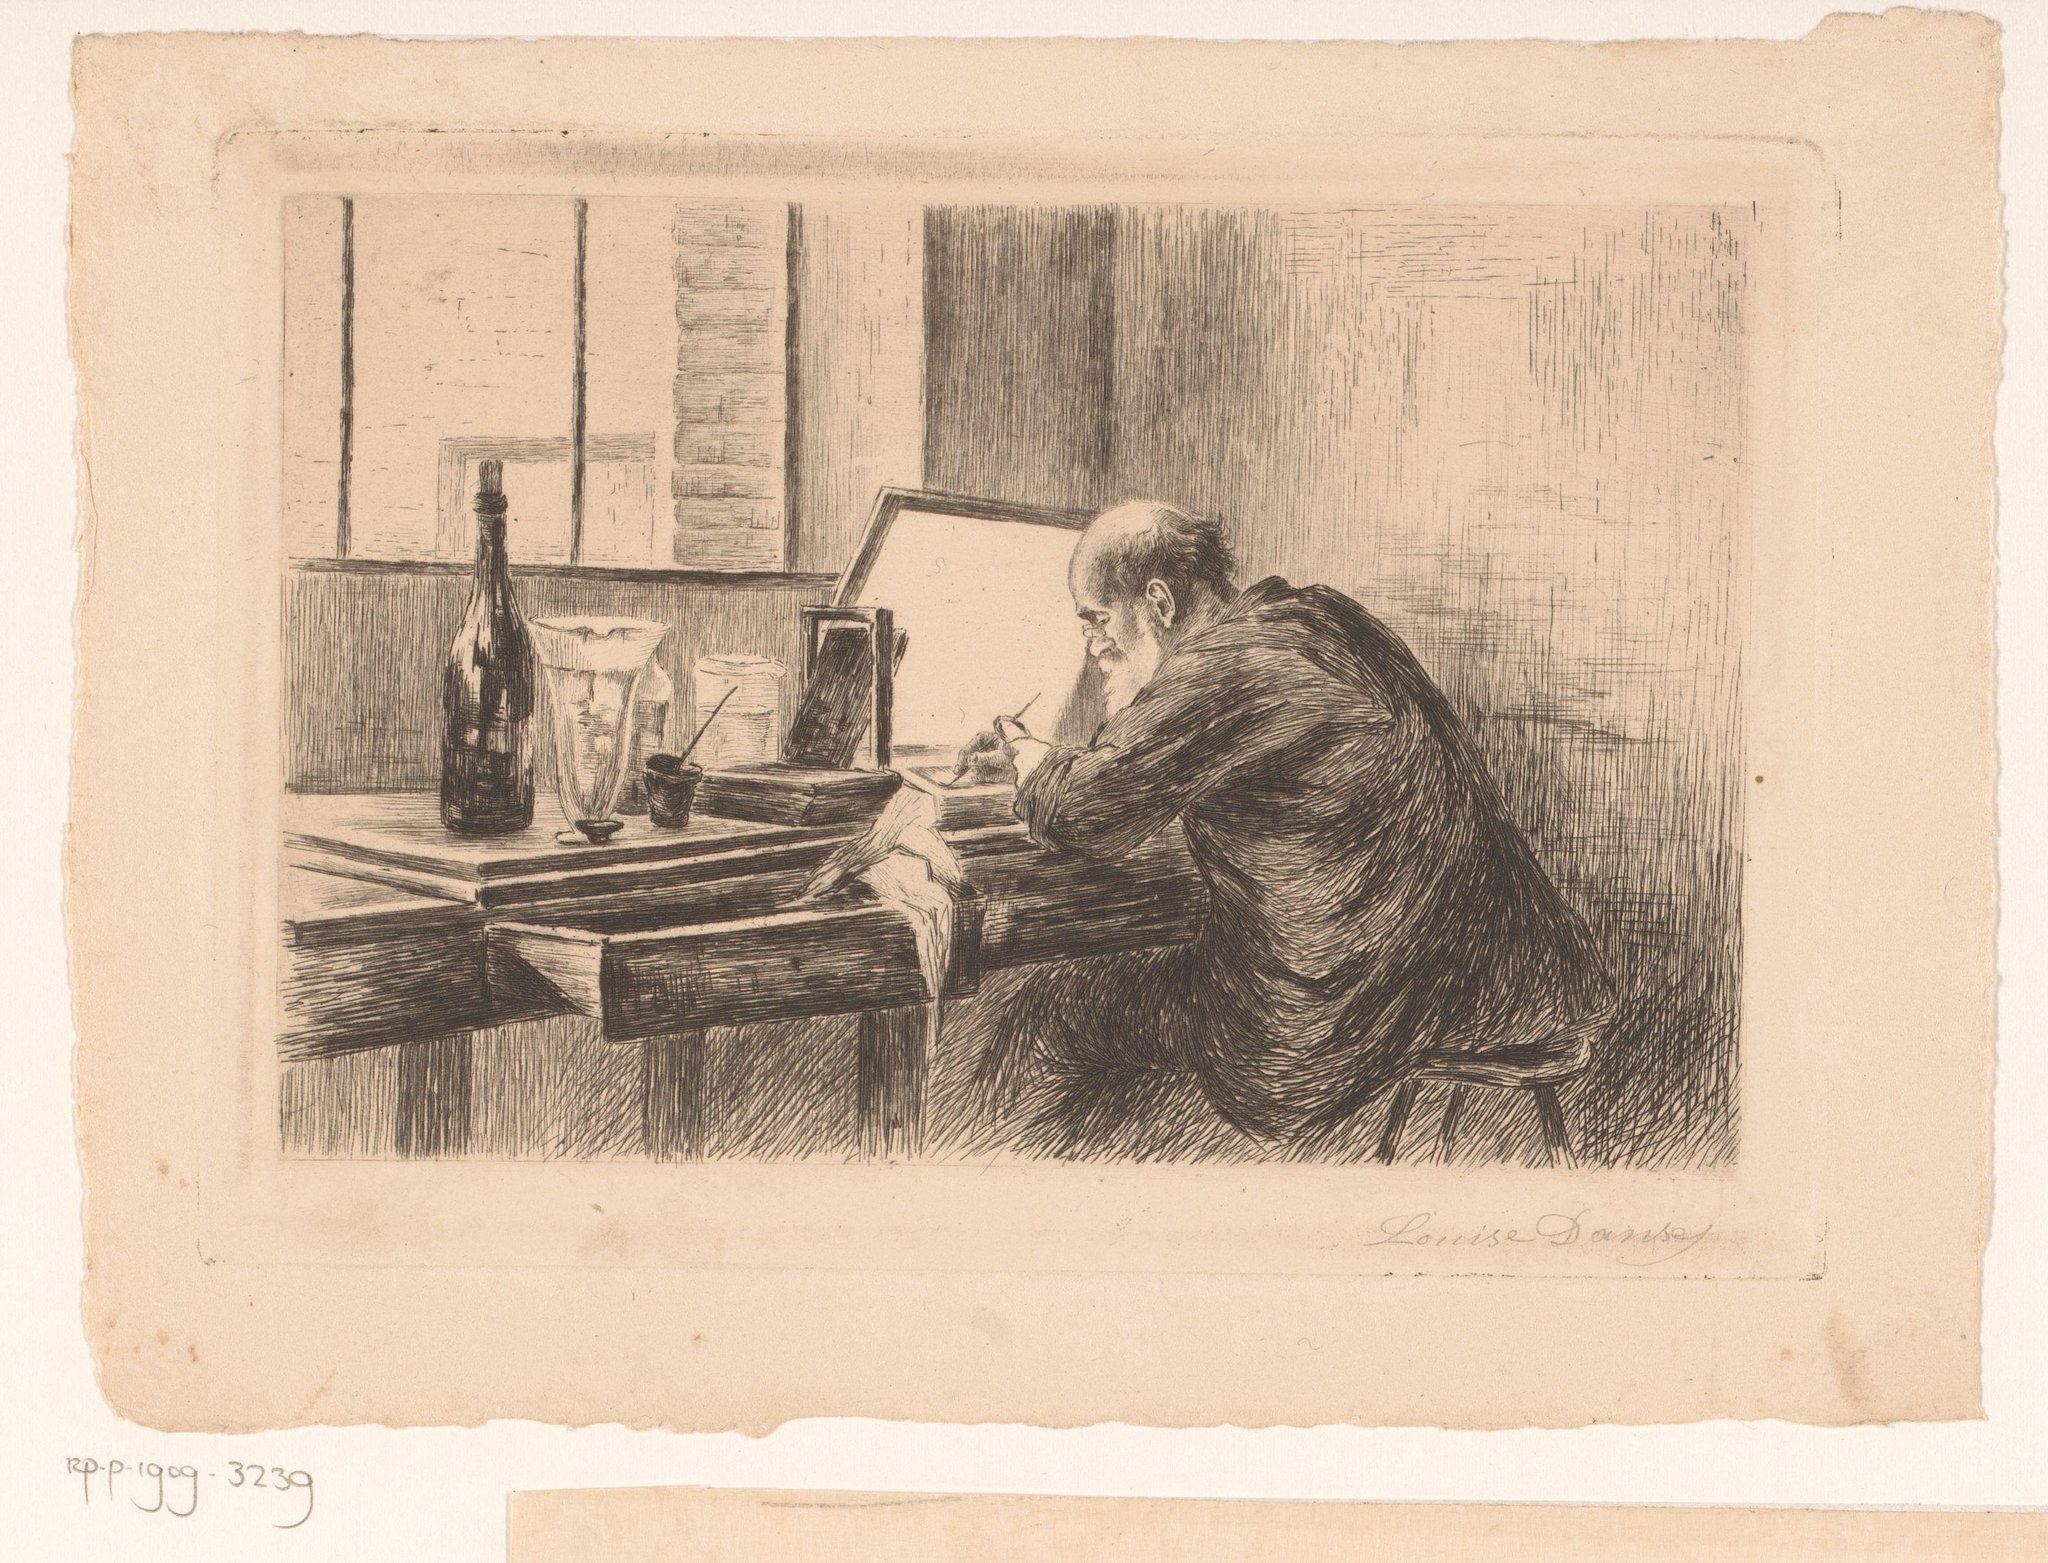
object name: print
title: Auguste Danse aan het etsen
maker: louise danse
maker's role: painter, print maker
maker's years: 1867-1948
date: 1877-1909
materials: paper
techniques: etching, intaglio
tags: etching, graphic artist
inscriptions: collector's mark: Lugt 2228